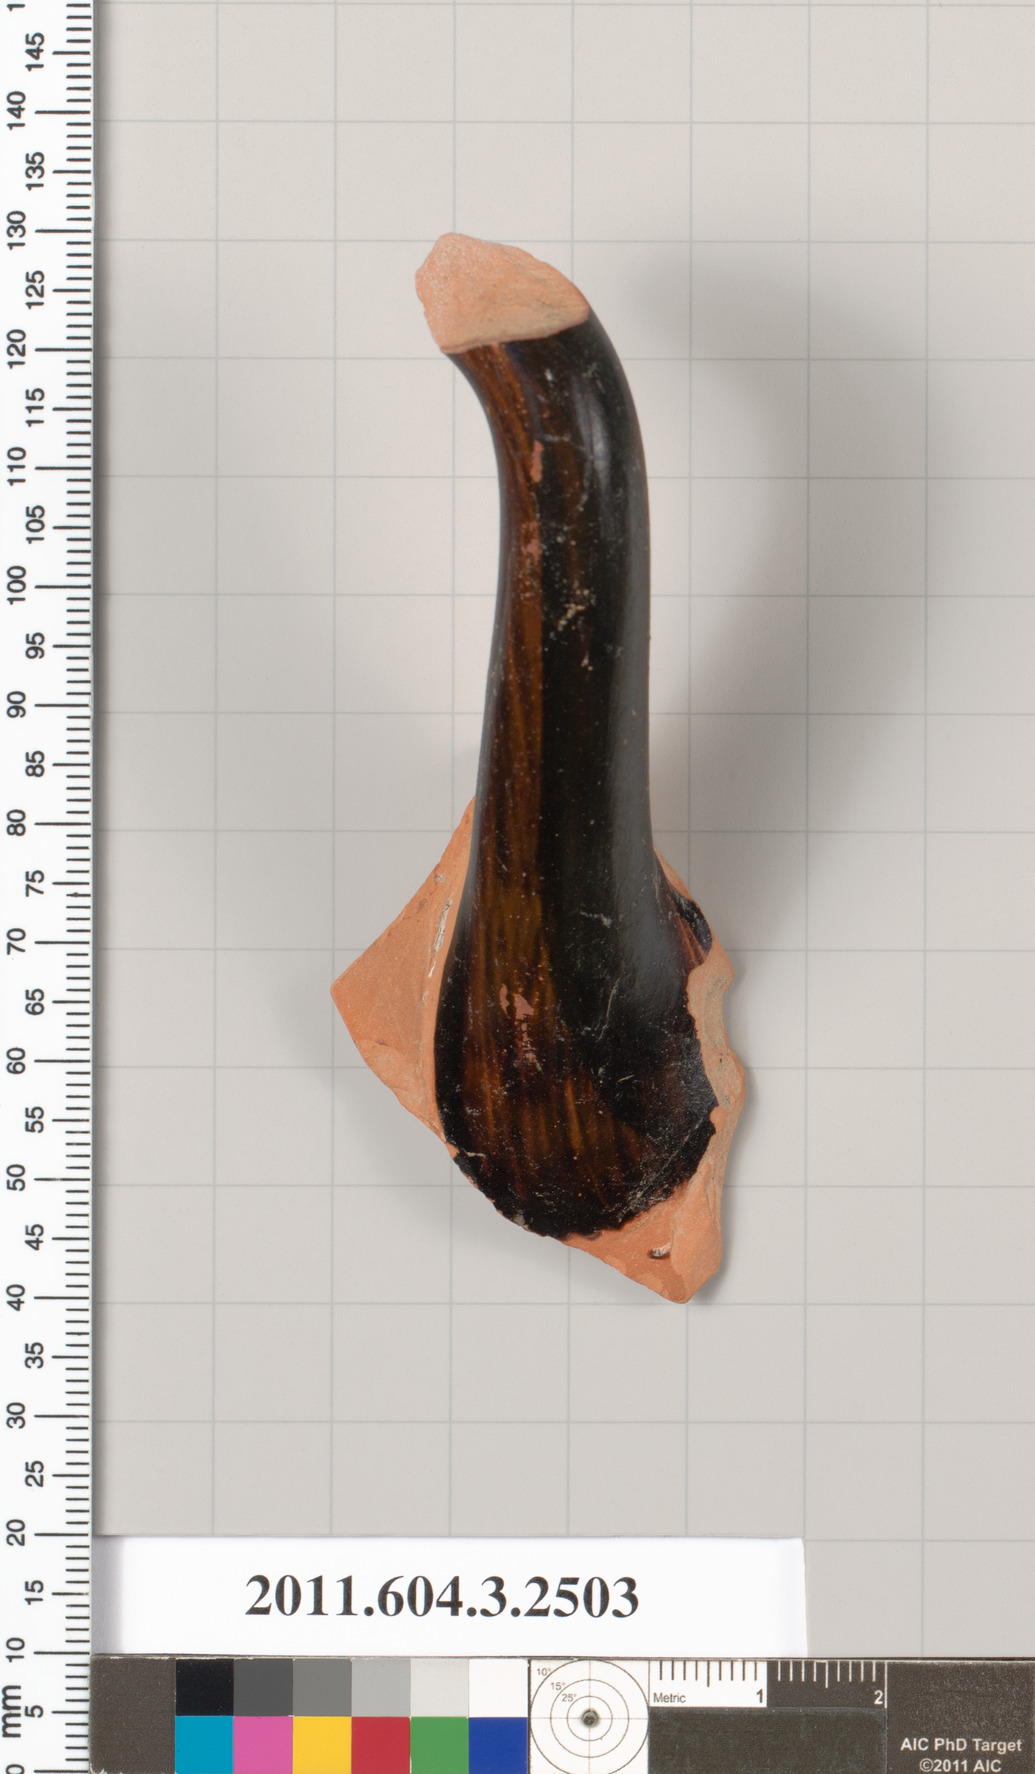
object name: kylix fragment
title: Terracotta fragment of a kylix (drinking cup)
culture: greek, attic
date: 600-401 BCE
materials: terracotta